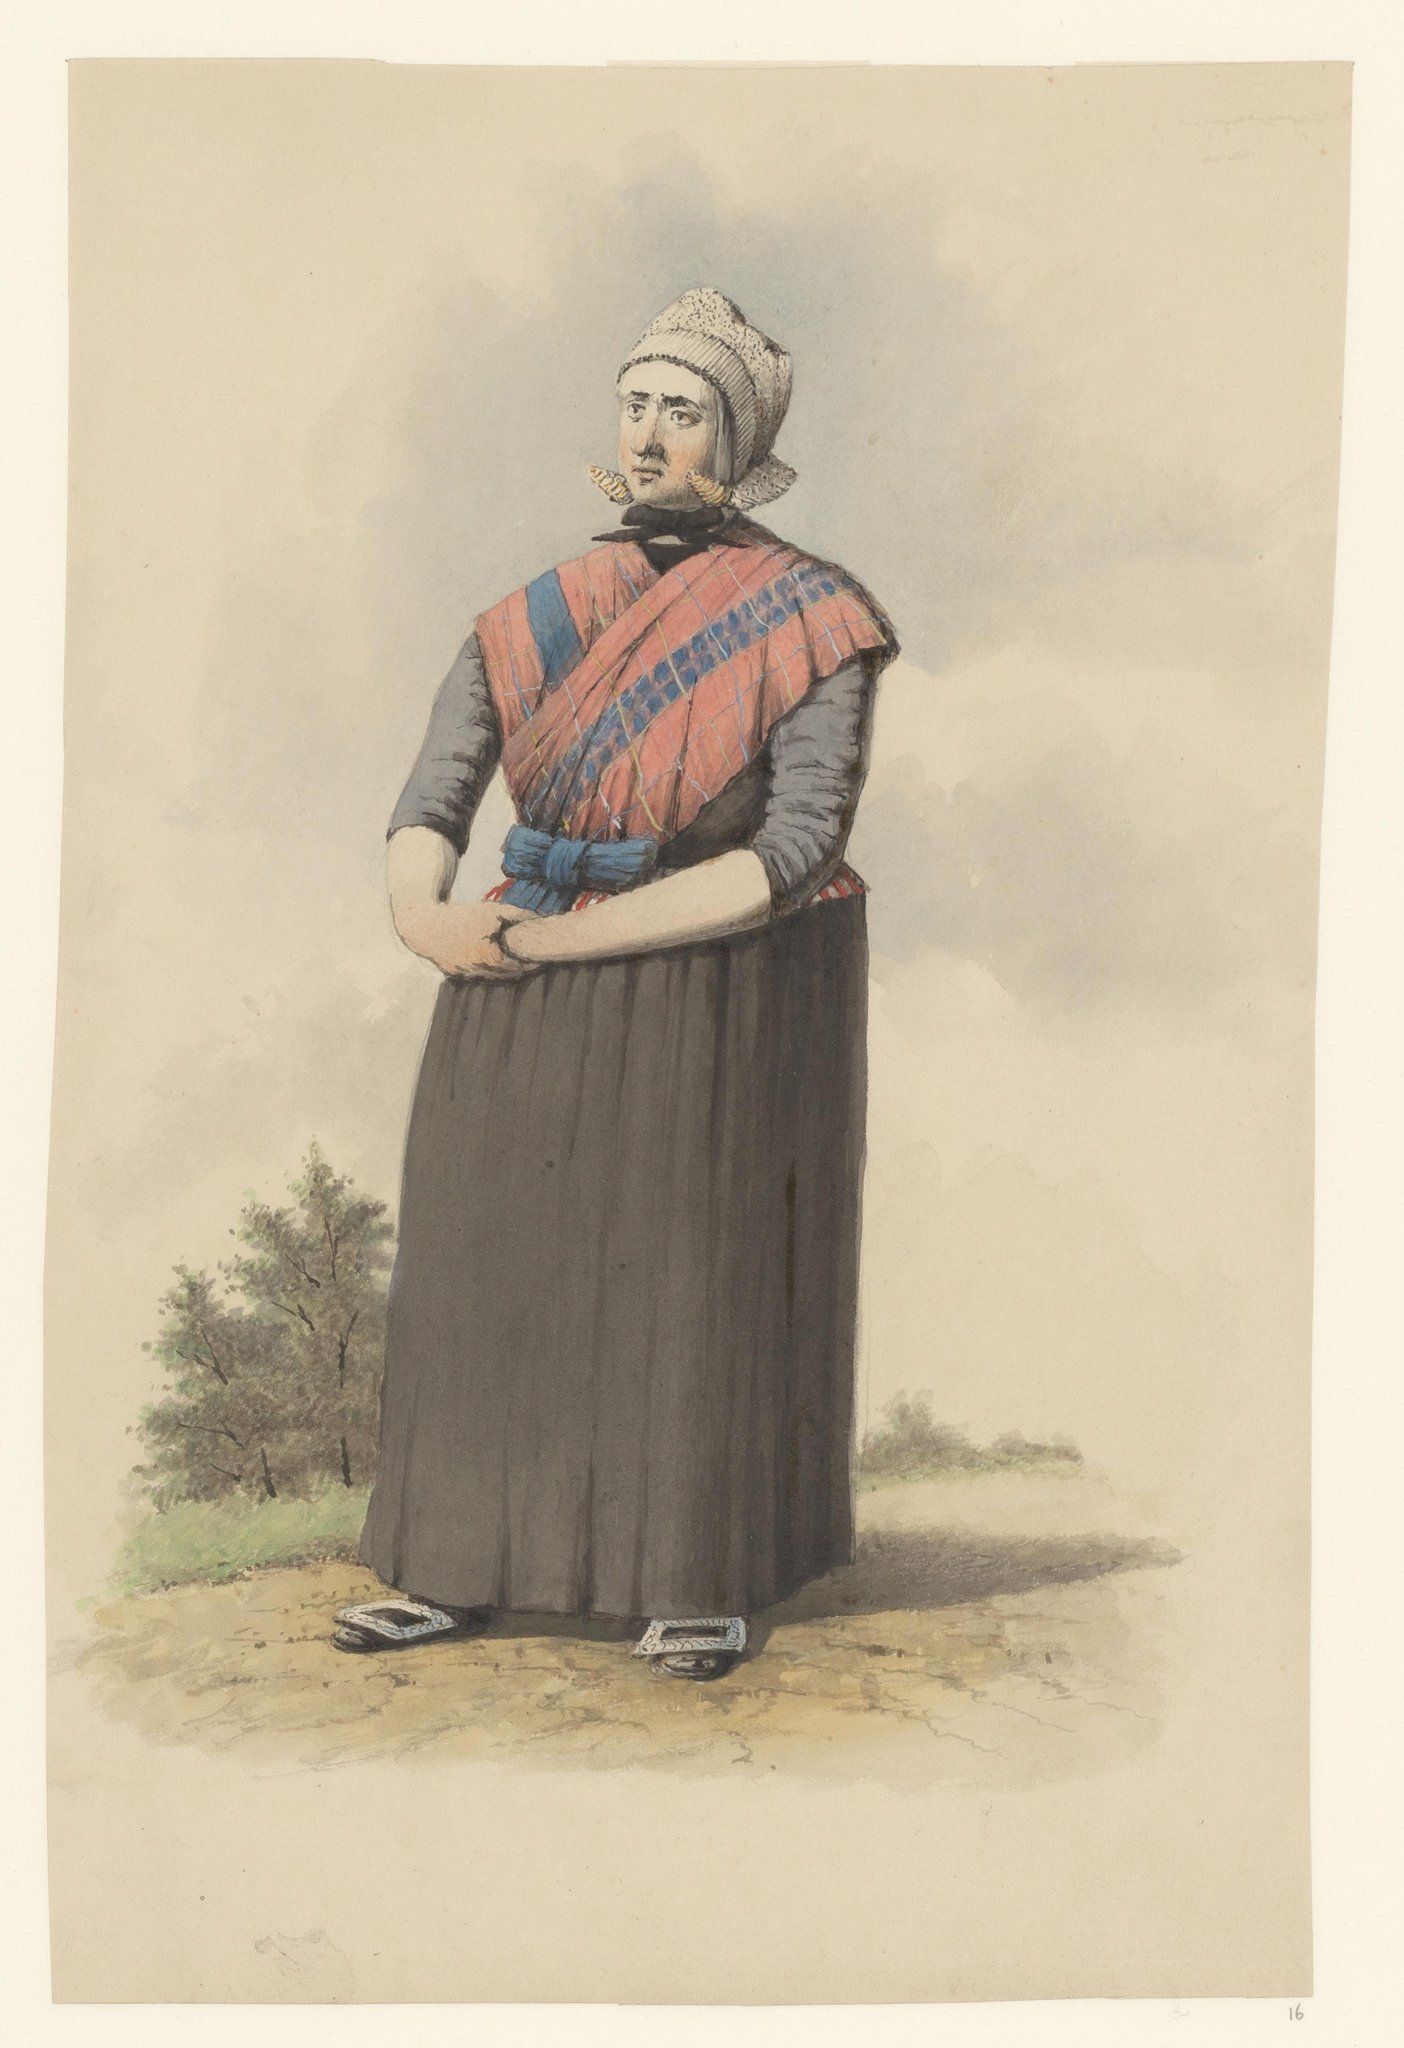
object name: drawing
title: Boerin uit Staphorst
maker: johan martinus anthon rieke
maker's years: 1851-1899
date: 1896-1898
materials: paper, watercolor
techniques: brush, hand coloring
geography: netherlands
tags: farmers - aa - female farmer, farmer's wife, clothes, costume (+ women's clothes), folk costume, regional costume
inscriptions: collector's mark: Lugt 1641, collector's mark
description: Boerin uit Staphorst, in haar zondagse kleding. Tekening vervaardigd voor de tentoonstelling over Nederlandse klederdrachten gehouden in het Stedelijk Museum te Amsterdam in september 1898. Onderwerpsrubrieken binnen de Atlas Zeden en Gewoonten: De Kleeding, Volkskleederdracht, Overijssel.